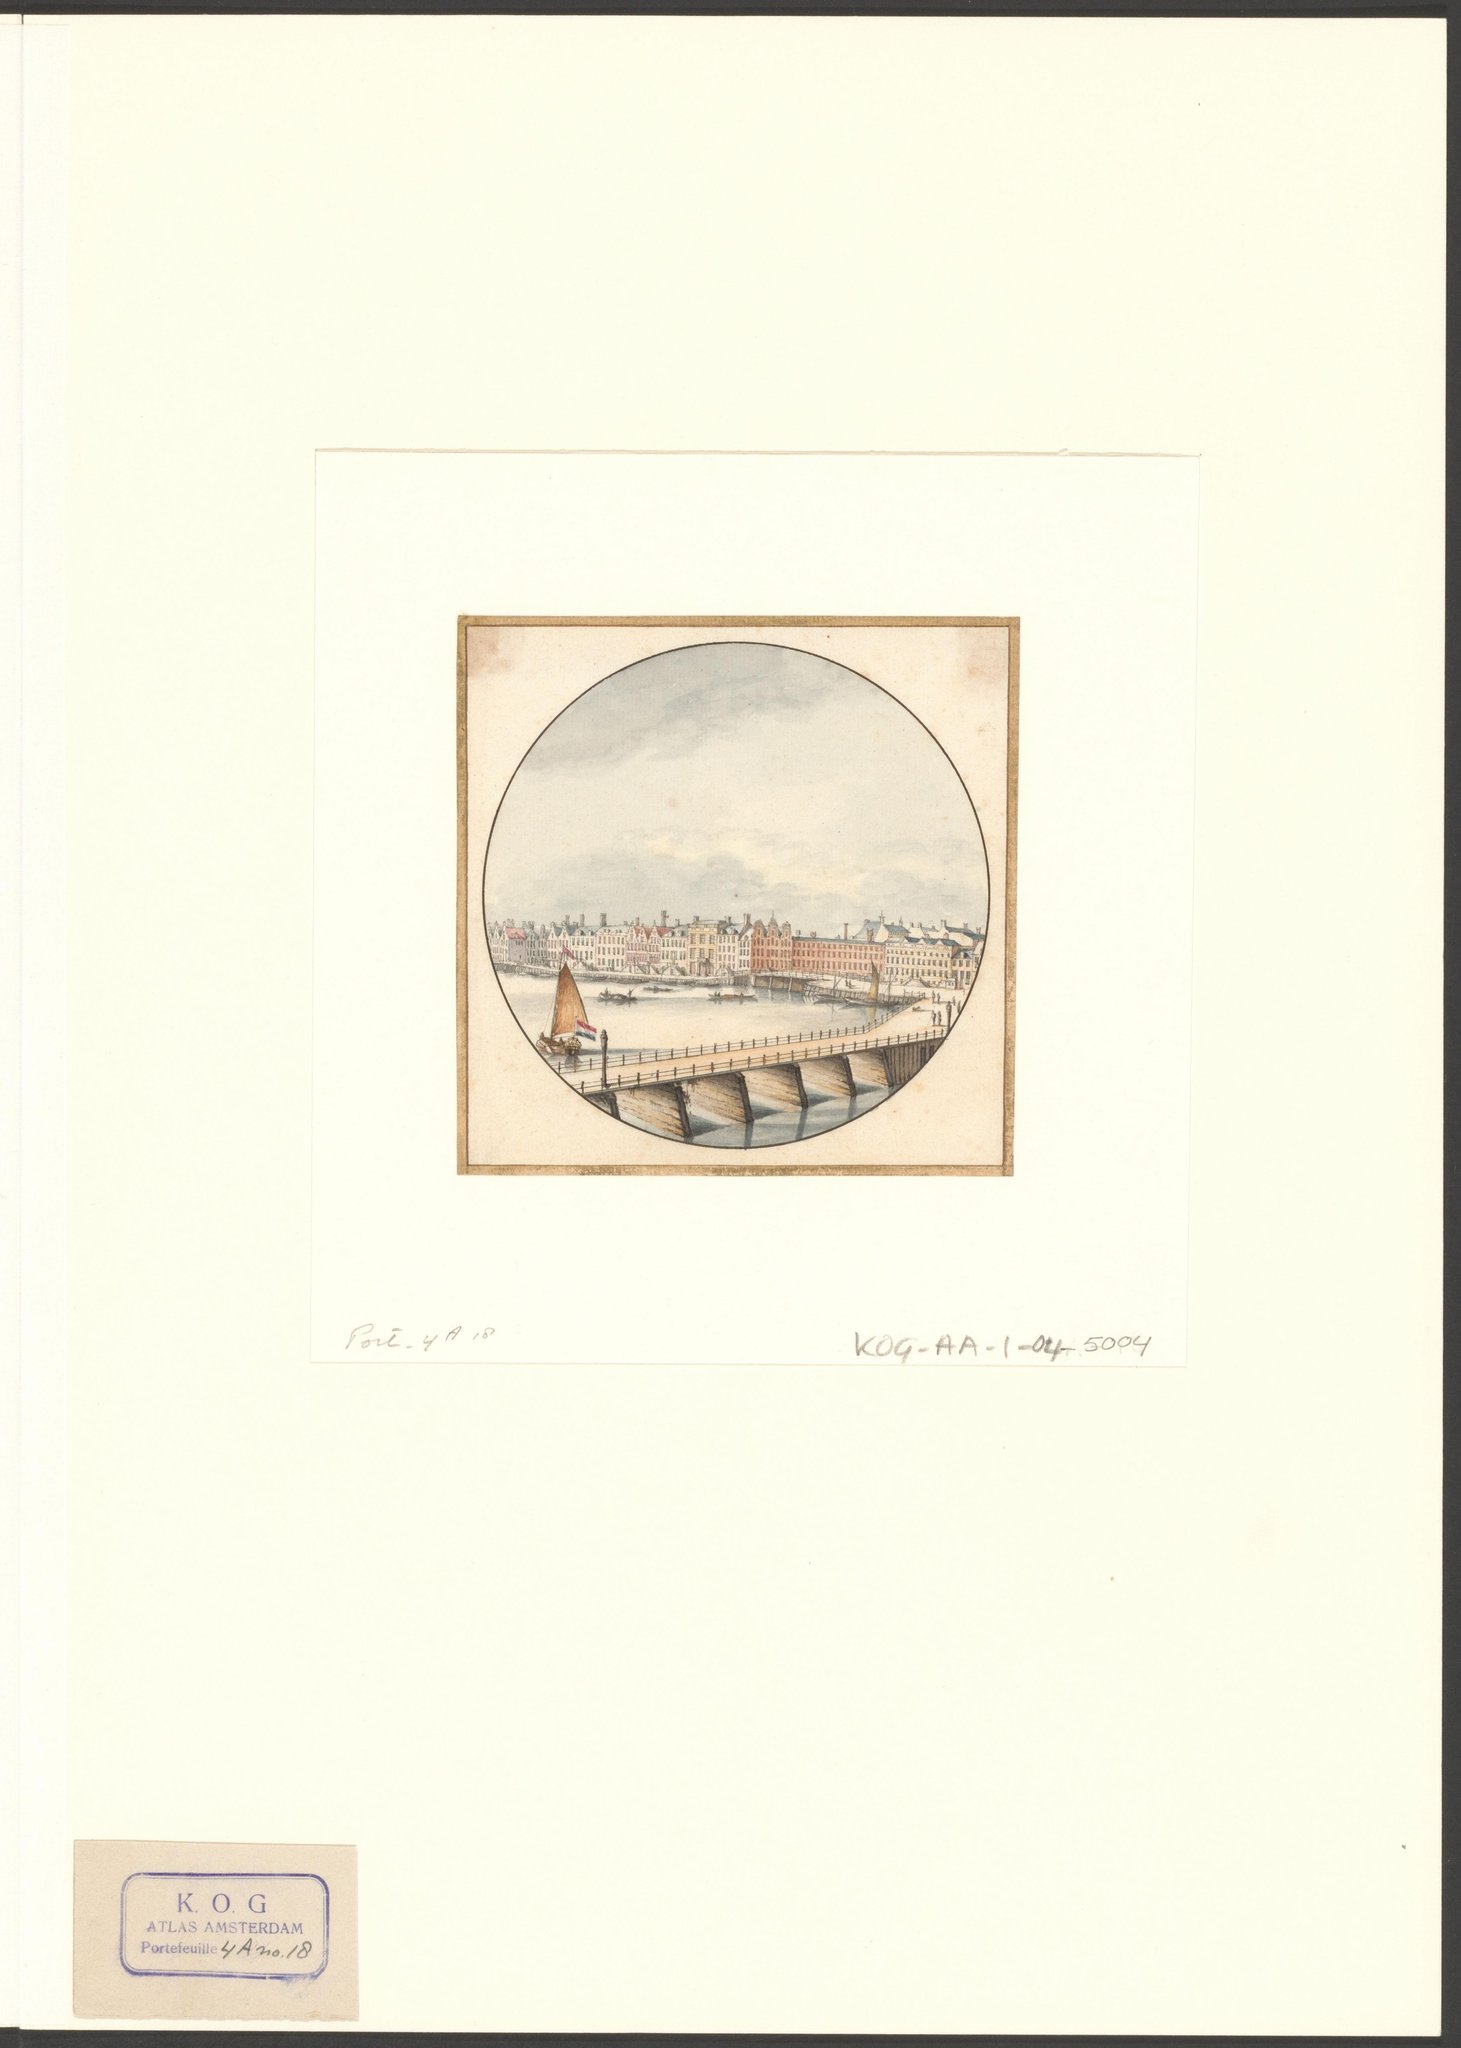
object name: drawing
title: Gezicht op de Amstel bij de ingang van de Herengracht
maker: jan van call (i)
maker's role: draughtsman, print maker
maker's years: 1656-1706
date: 1666-1703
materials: paint, ink, paper, pencil, watercolor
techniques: brush, pen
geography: amsterdam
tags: sailing-ship, sailing-boat, city-view in general; 'veduta', canal, bridge in city across river, canal, etc.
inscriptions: inscription: ‘Port. 4a18’, collector's mark: ‘4A’ Lugt 1641b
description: Onderwerpsrubriek binnen de Atlas Amsterdam: Amstel van Doelensluis tot Blauwbrug.